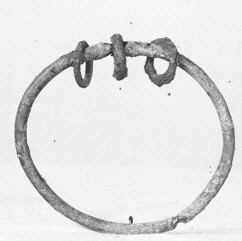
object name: rattle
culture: italian, roman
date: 100 BCE-200 CE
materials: bronze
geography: italy